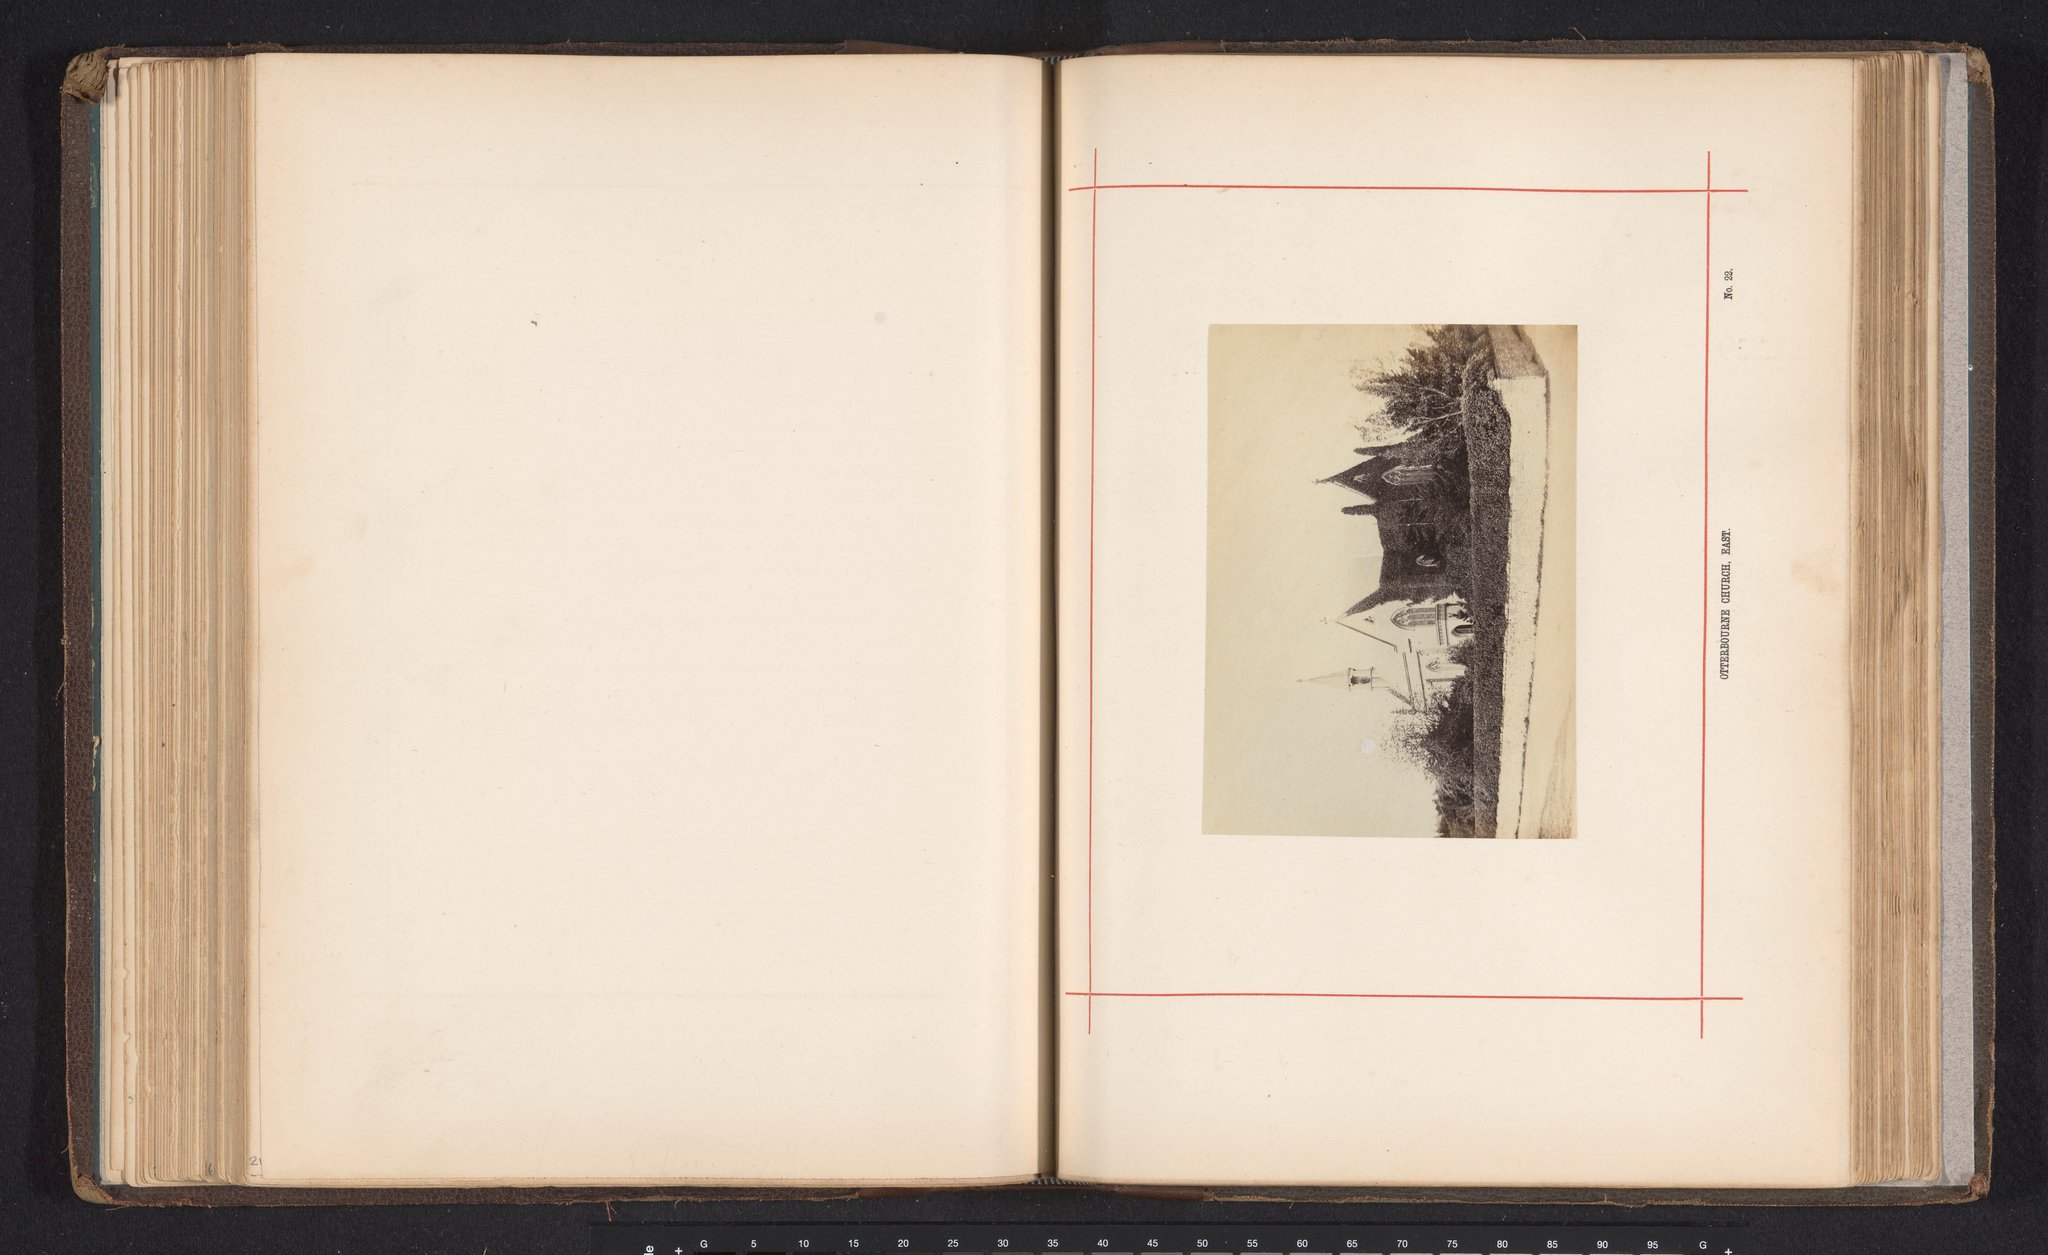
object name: photograph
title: Gezicht op Saint Matthew's Church te Otterbourne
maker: william savage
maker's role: fotograaf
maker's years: 1817-1887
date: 1861-1866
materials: paper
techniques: albumen print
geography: otterbourne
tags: church (exterior)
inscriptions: number: ‘No. 22.’